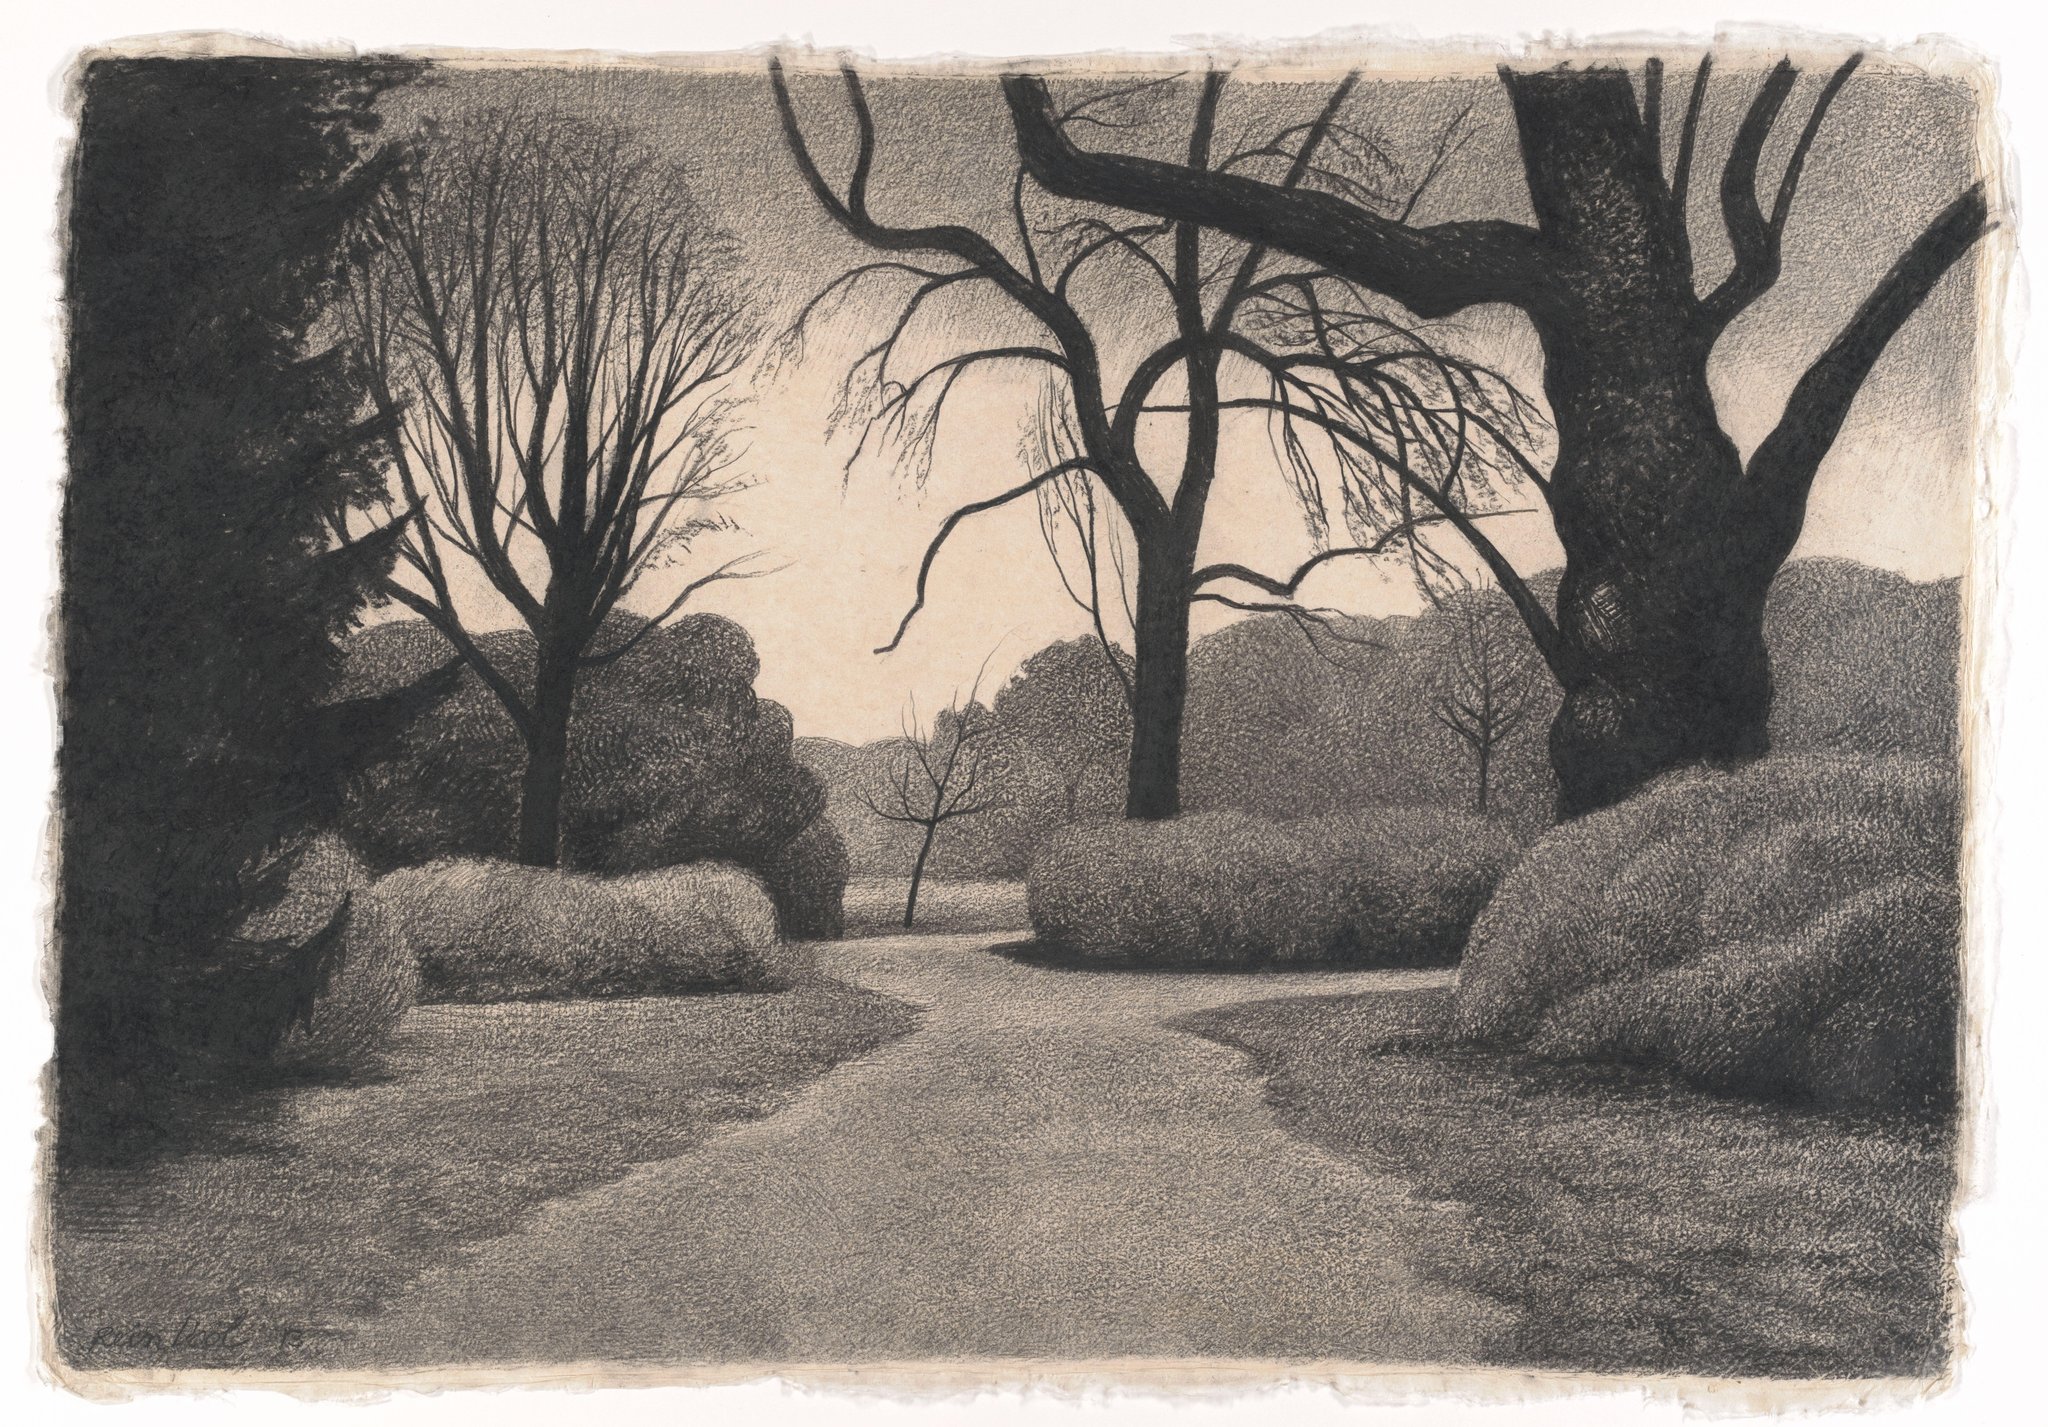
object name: drawing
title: Driesprong in het Wantijpark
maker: rein dool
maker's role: draughtsman, painter, print maker, sculptor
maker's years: 1933-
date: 2013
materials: charcoal, paper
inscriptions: signature and date